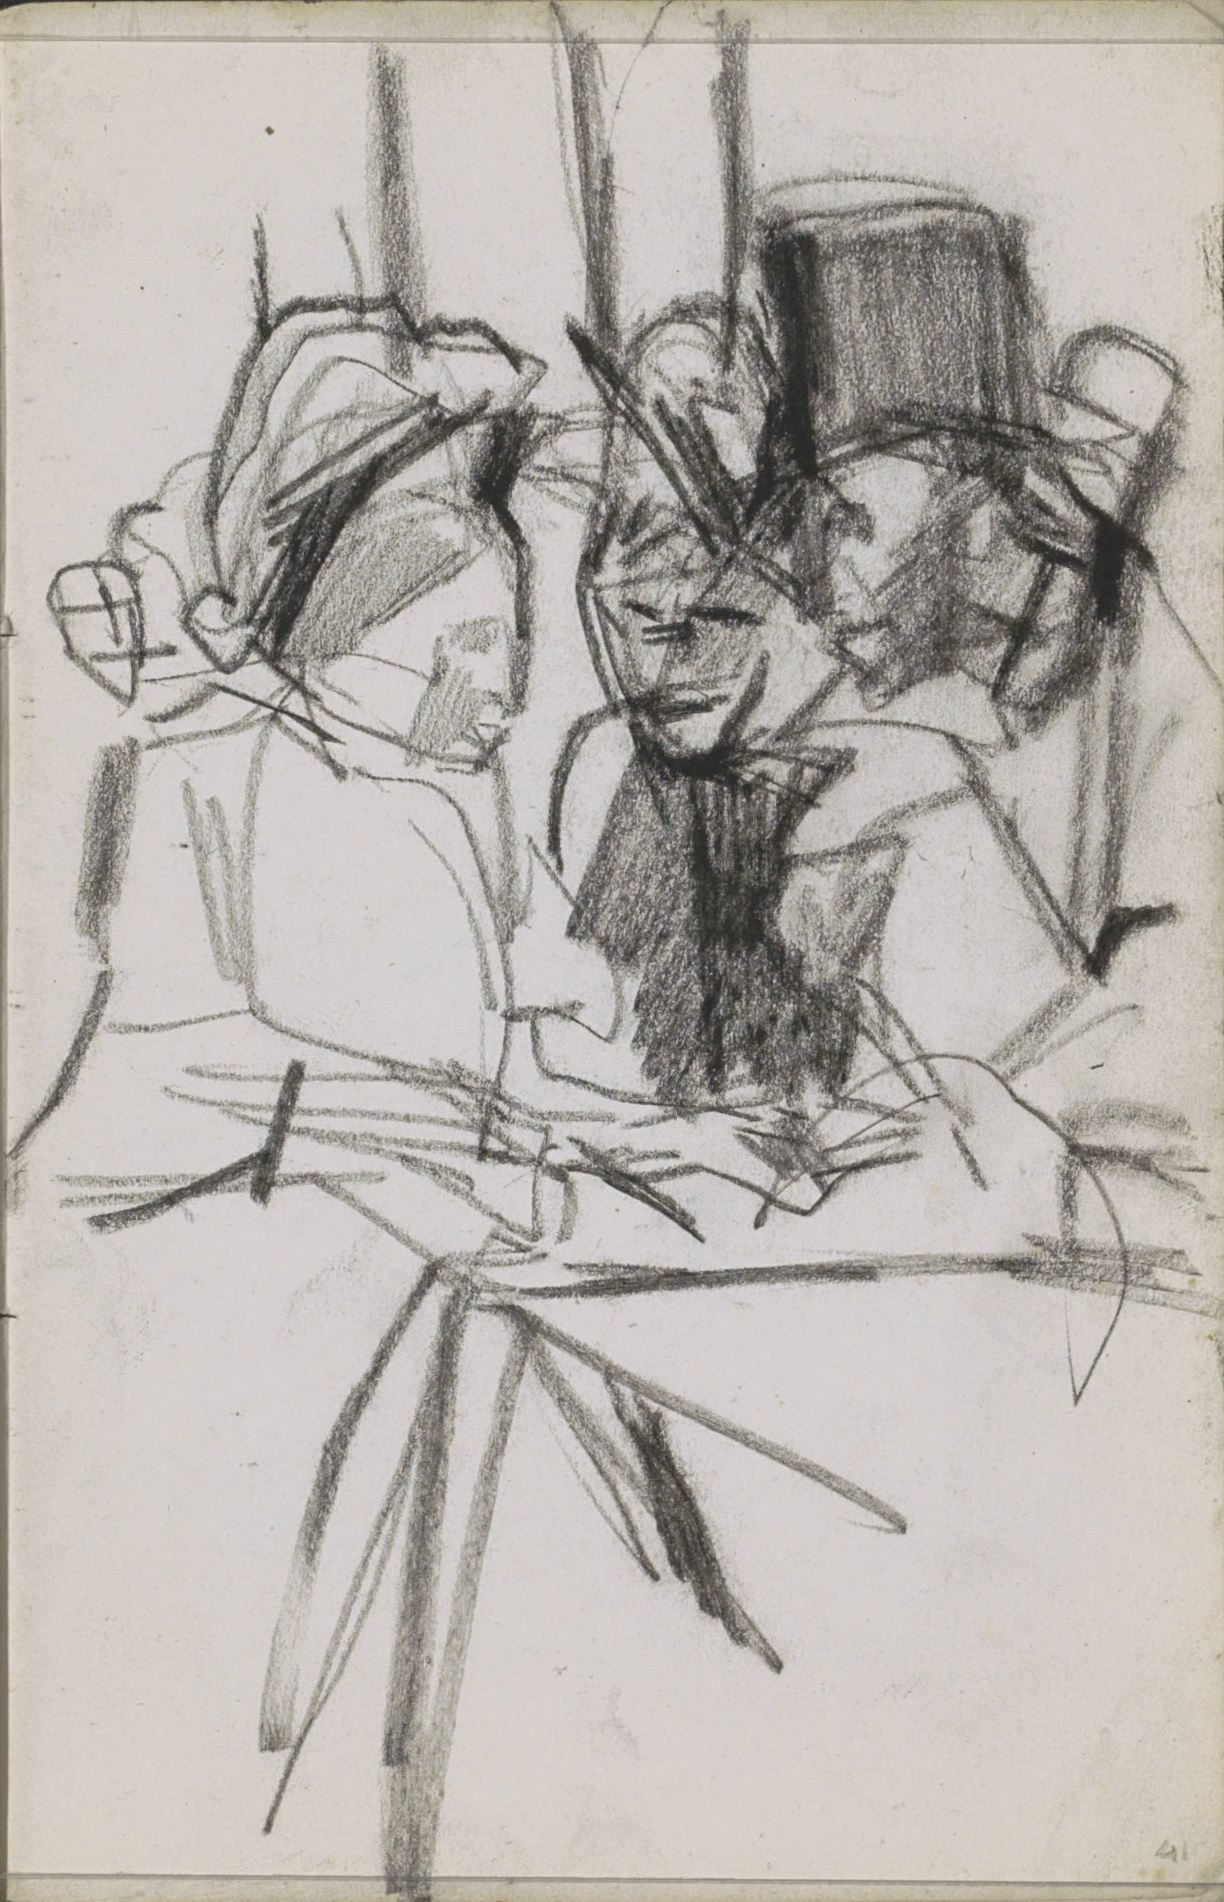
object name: sketchbook leaf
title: Drie zittende figuren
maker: isaac israels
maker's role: draughtsman, painter, print maker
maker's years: 1865-1934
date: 1875-1934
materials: chalk, paper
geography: amsterdam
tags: adult man (+ sitting), adult woman (+ sitting)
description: Pagina 41 uit schetsboek XXIX met 44 pagina's.